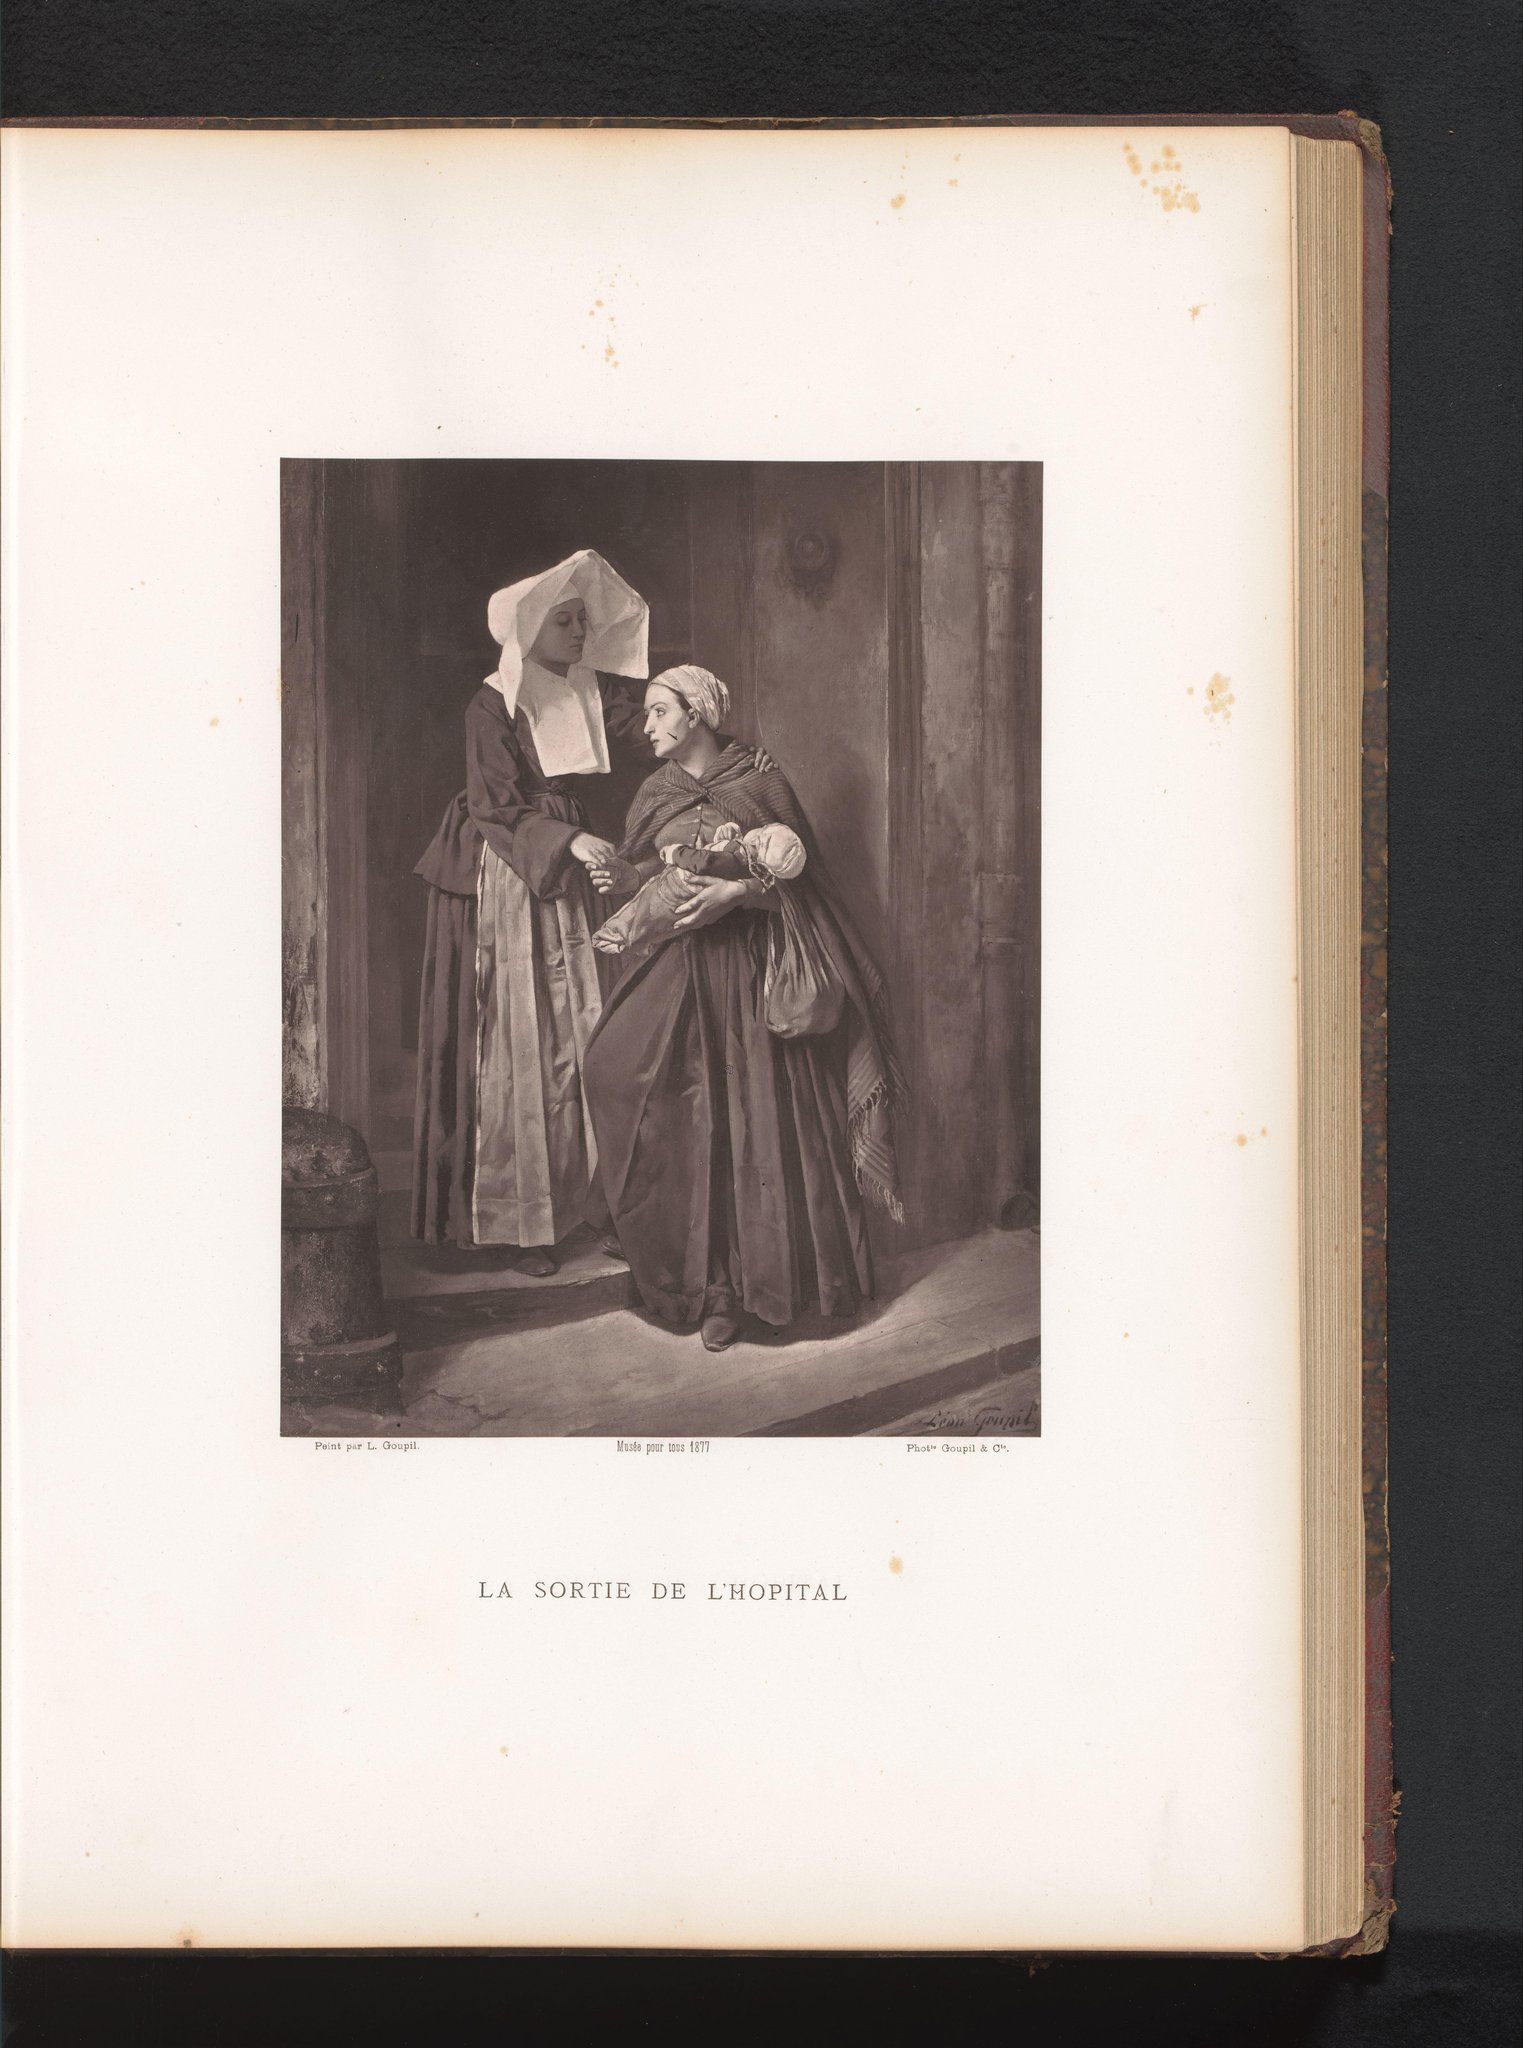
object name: photomechanical print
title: Reproductie van een schilderij van een vrouw die het ziekenhuis verlaat met haar baby door Léon-Lucien Goupil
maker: léon-lucien goupil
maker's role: painter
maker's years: 1834-1890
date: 1872-1879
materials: paper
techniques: woodburytype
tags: sick-bed, nursing, tending the sick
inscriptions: inscription: ‘Musée pour tous 1877’